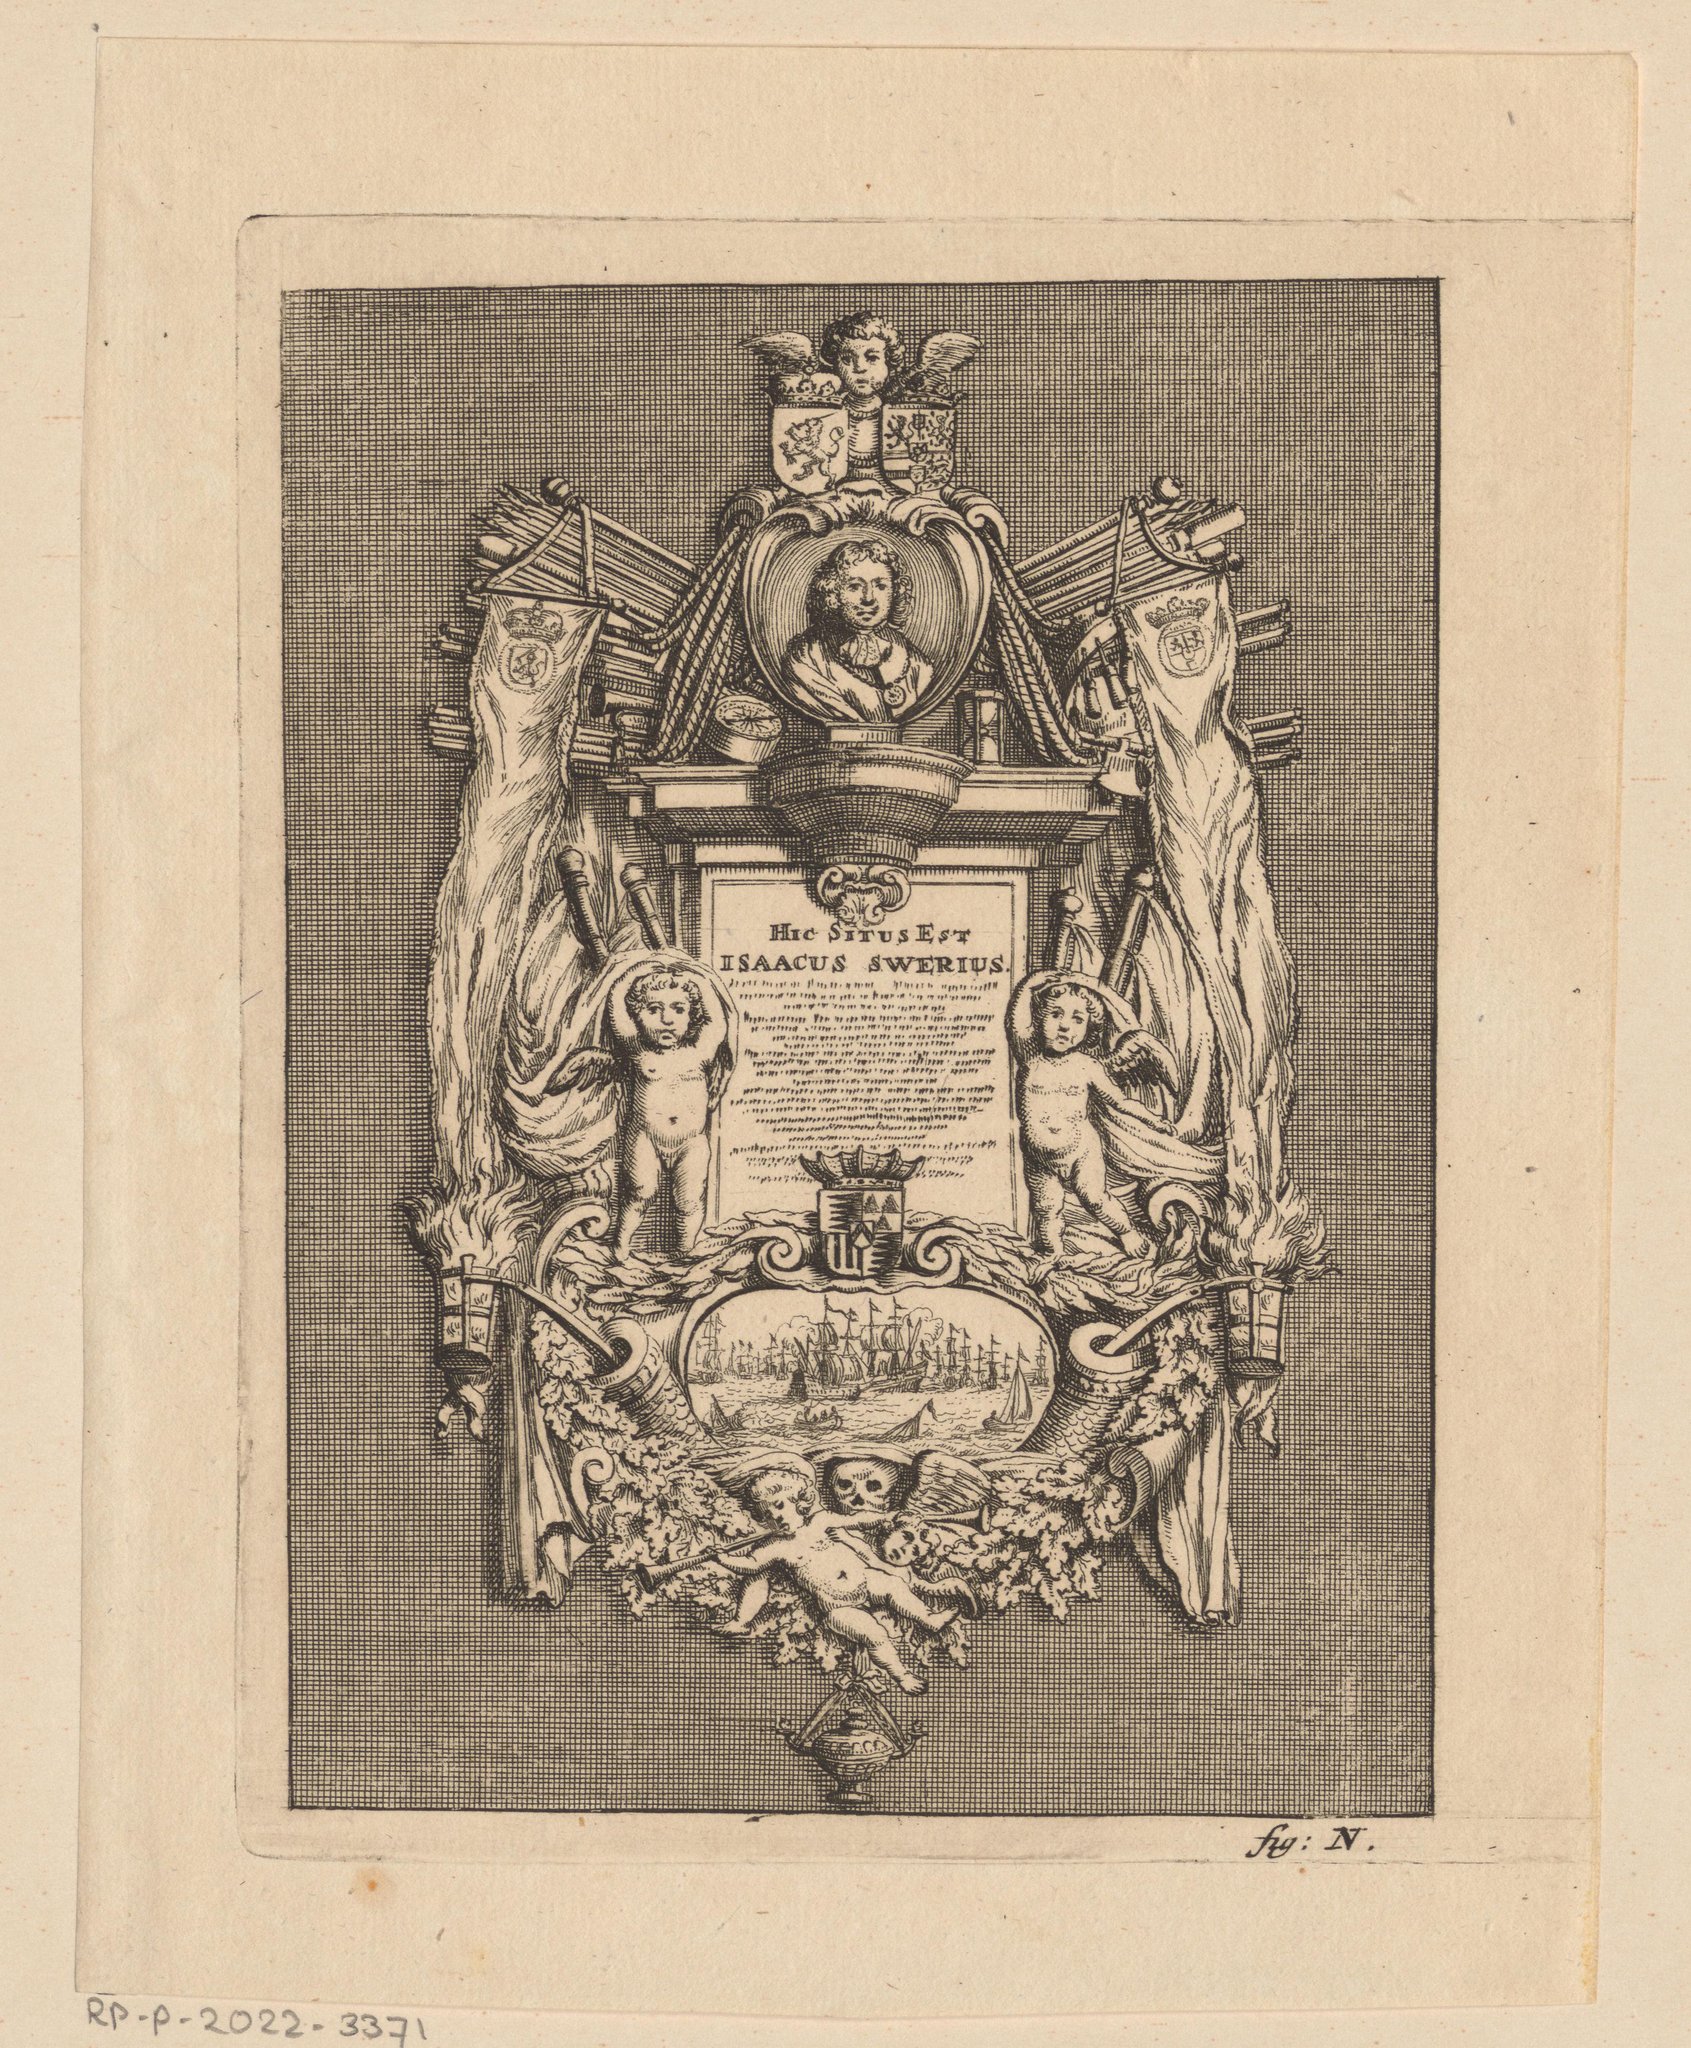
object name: print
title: Grafteken voor Isaac Sweers in de Oude Kerk te Amsterdam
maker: Anonymous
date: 1690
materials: paper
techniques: engraving, etching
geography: northern netherlands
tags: nijmegen, coat of arms (as symbol of the state, etc.), casting weapons: spear, hourglass, ships (in general) - cc - more than one ship, grave-building, monumental tomb, compass, cupids: 'amores', 'amoretti', 'putti', armorial bearing, heraldry, death's head, skull (symbol of death)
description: Prent waarschijnlijk uit: Bizot, Pierre. Medalische historie der republyk van Holland. Amsterdam: Pieter Mortier, 1690.